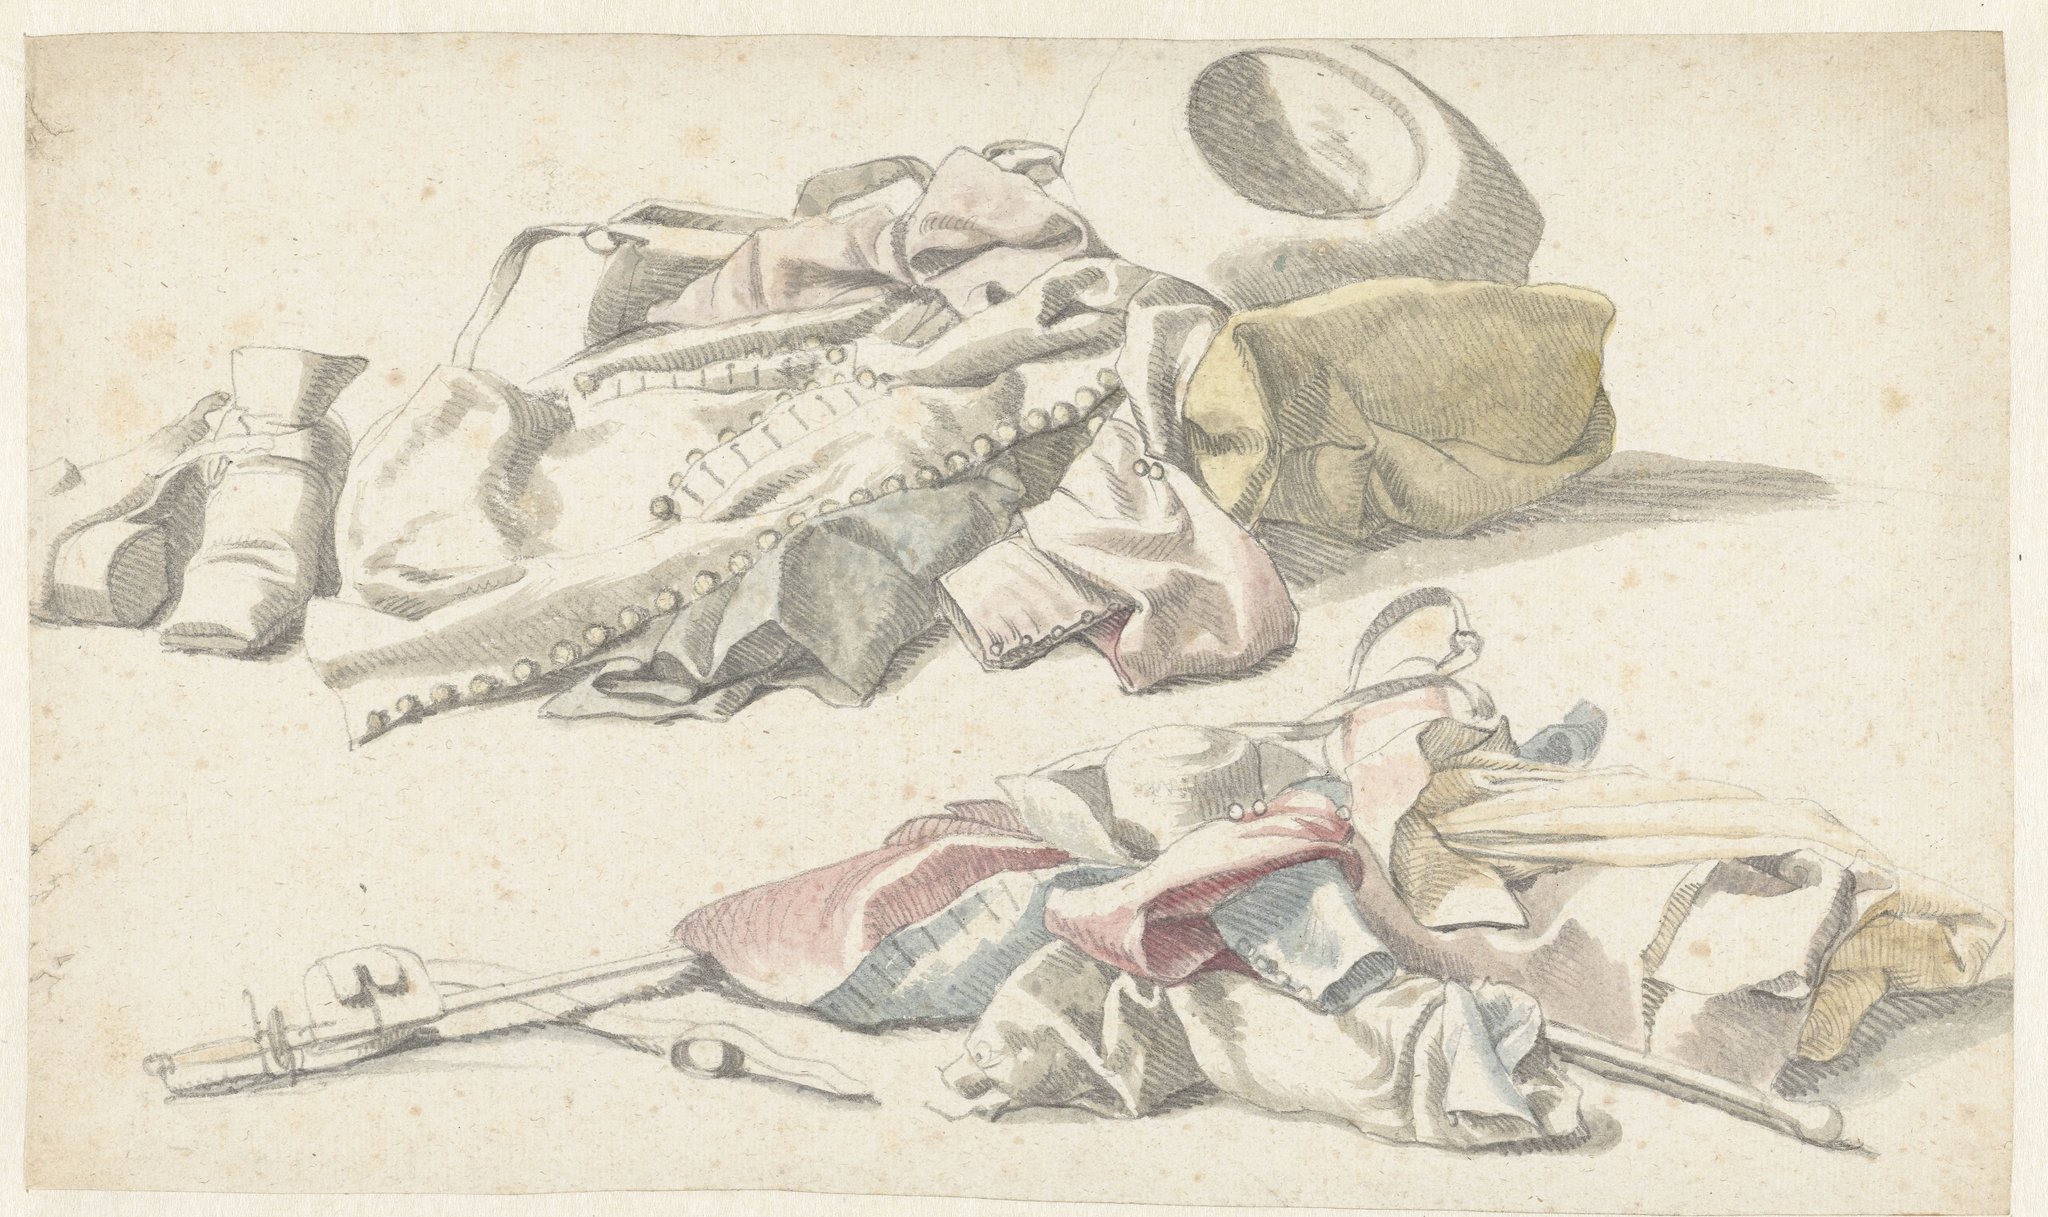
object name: drawing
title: Twee stillevens van de plunje van een soldaat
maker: Anonymous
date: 1600-1699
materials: paper, pencil, watercolor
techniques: brush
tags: still life of related objects, (military) uniforms